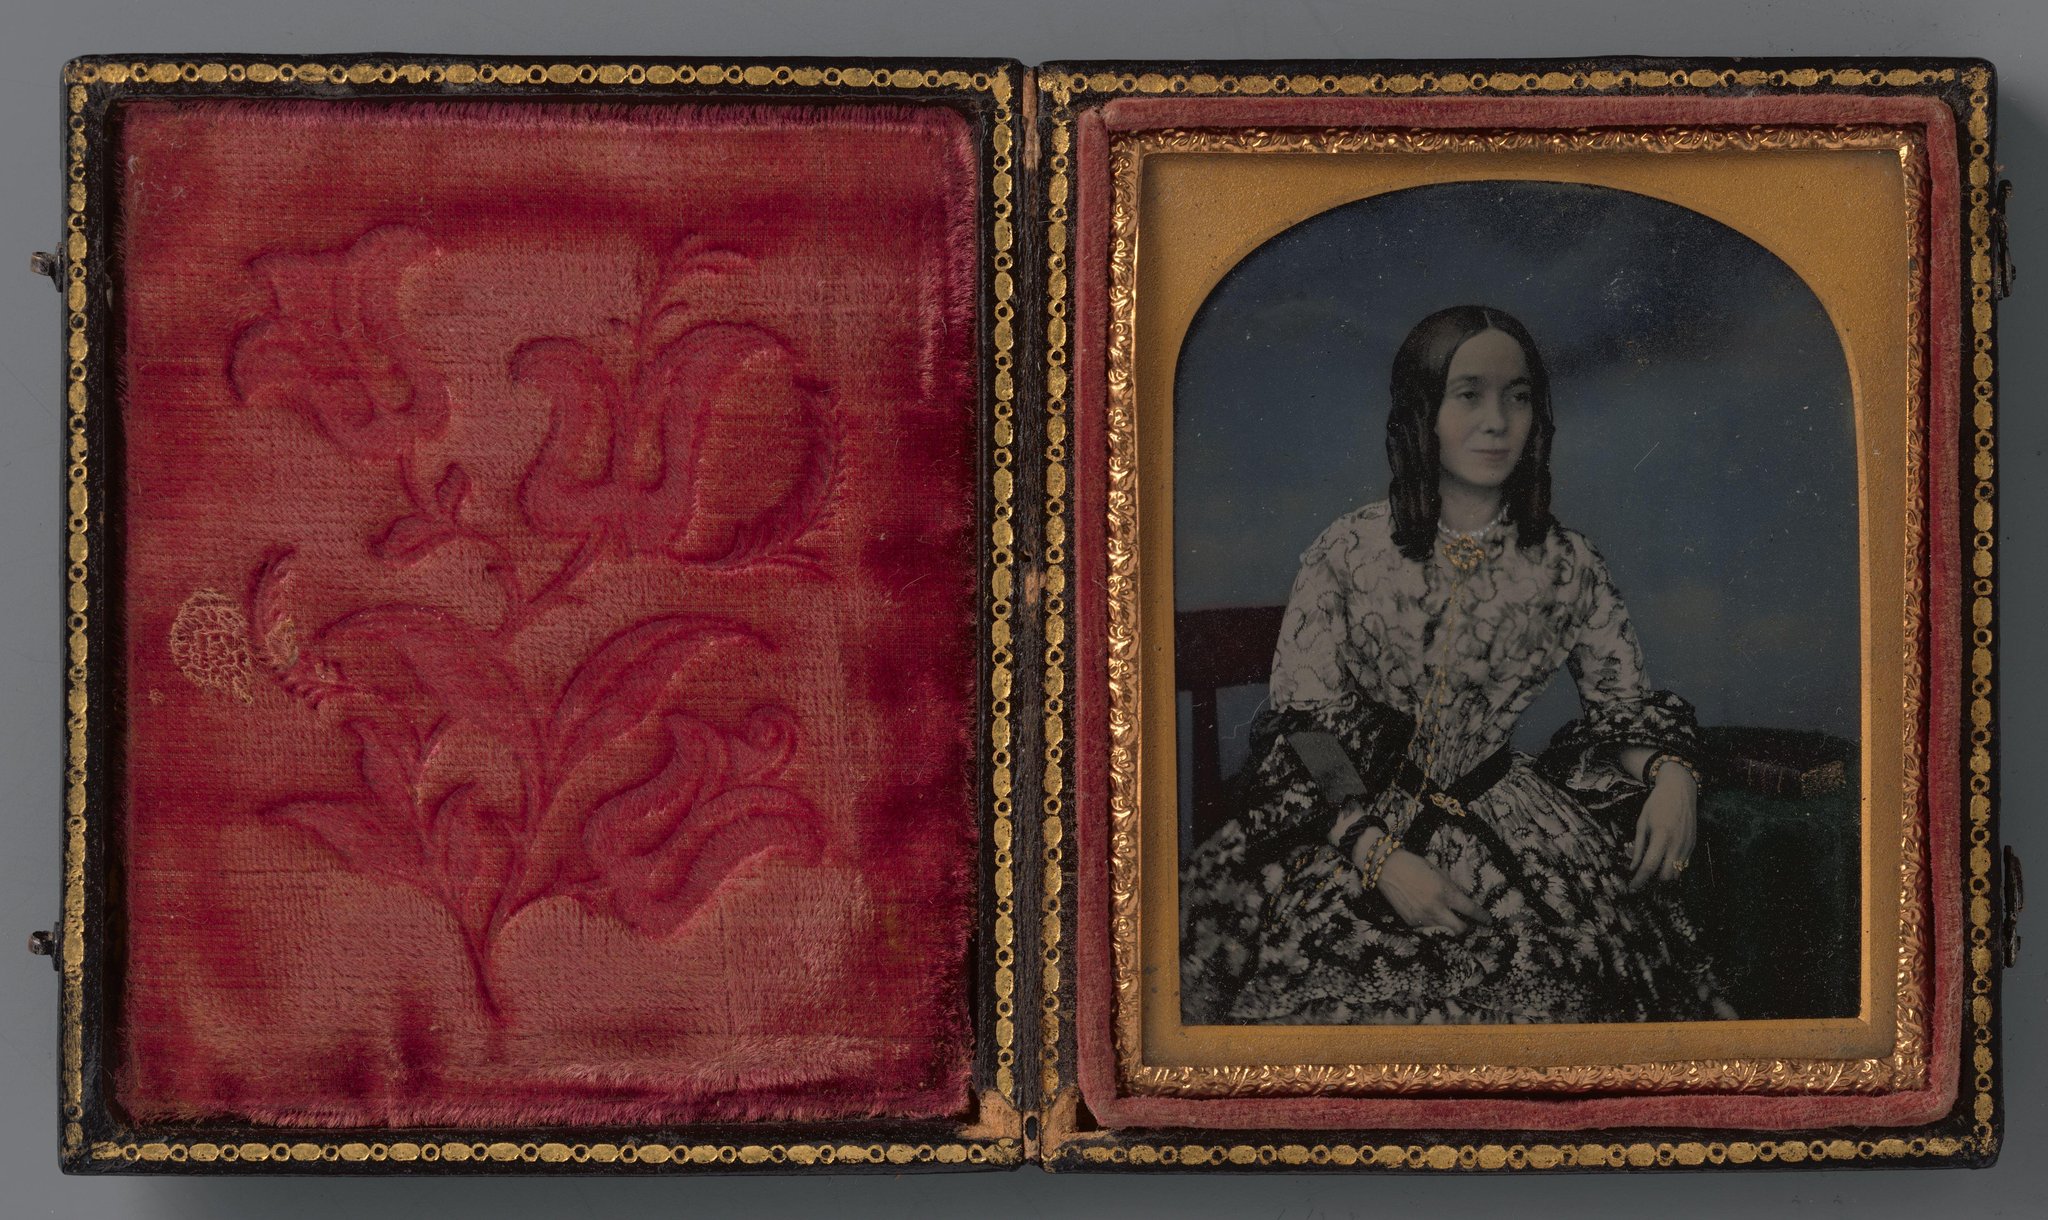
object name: photograph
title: Portret van een onbekende jonge vrouw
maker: Anonymous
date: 1855-1870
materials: glass, metal, velvet, wood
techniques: ambrotype, hand coloring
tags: adolescent, young woman, maiden, sitting figure - aa - female human figure, historical persons - bb - woman